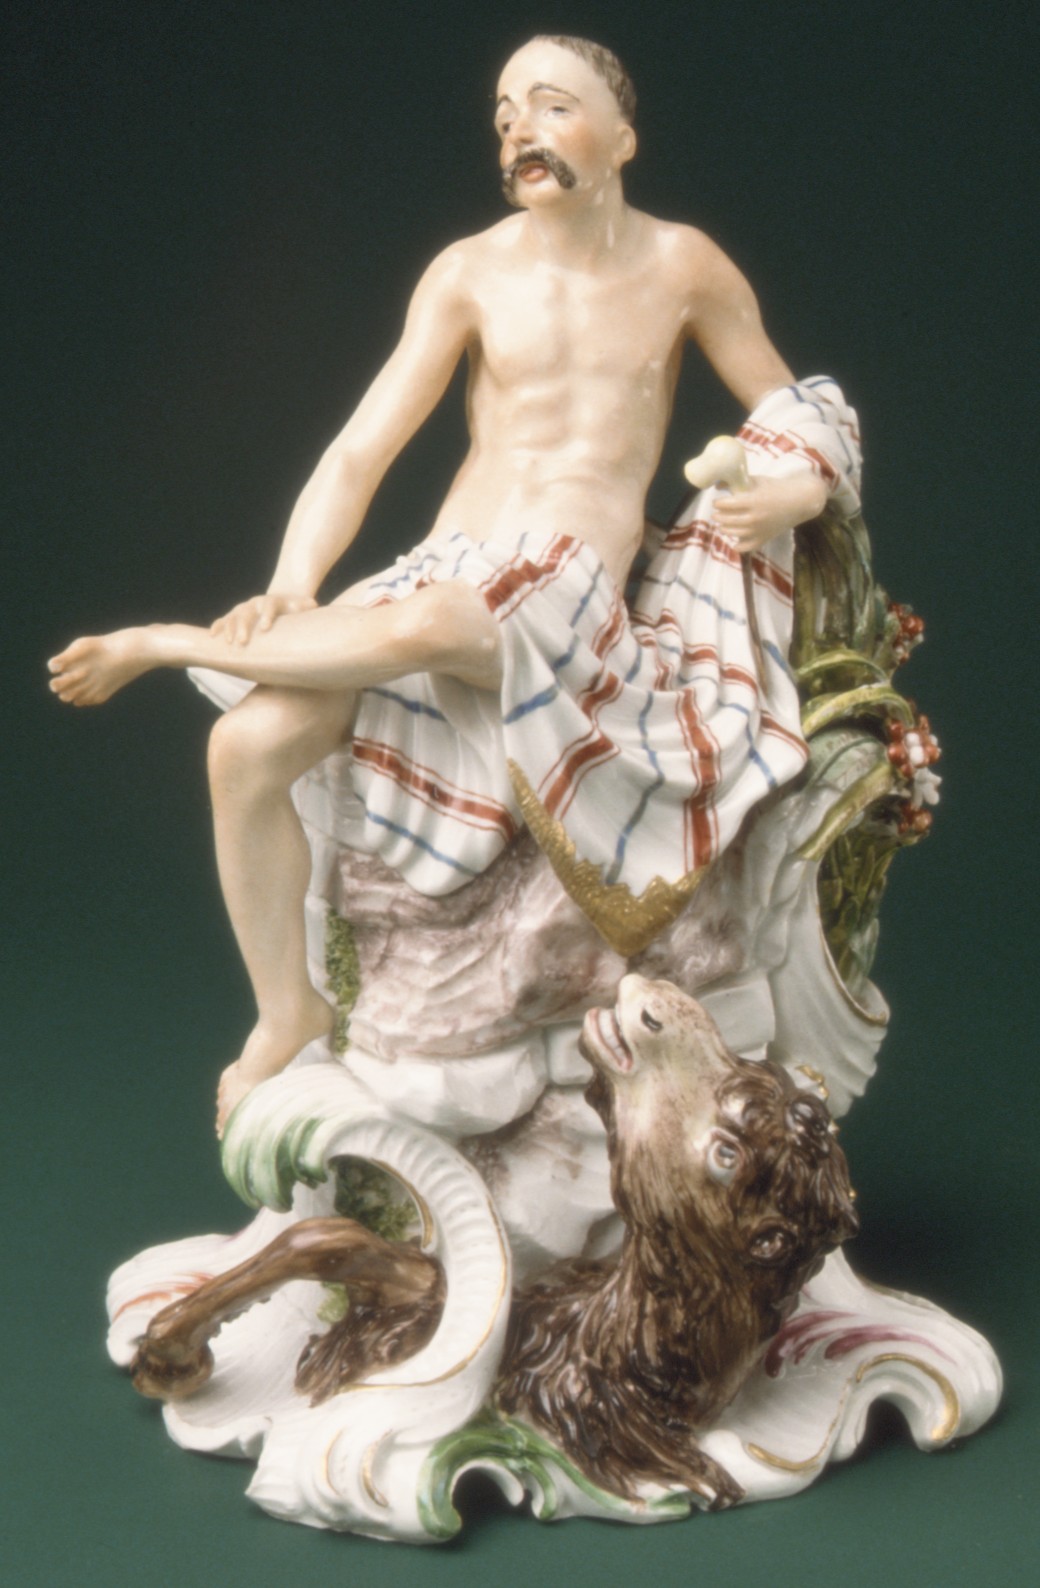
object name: figure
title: Asia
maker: nymphenburg porcelain manufactory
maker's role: manufactory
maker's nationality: german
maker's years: 1747-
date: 1763-1765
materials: hard paste porcelain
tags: animals,men